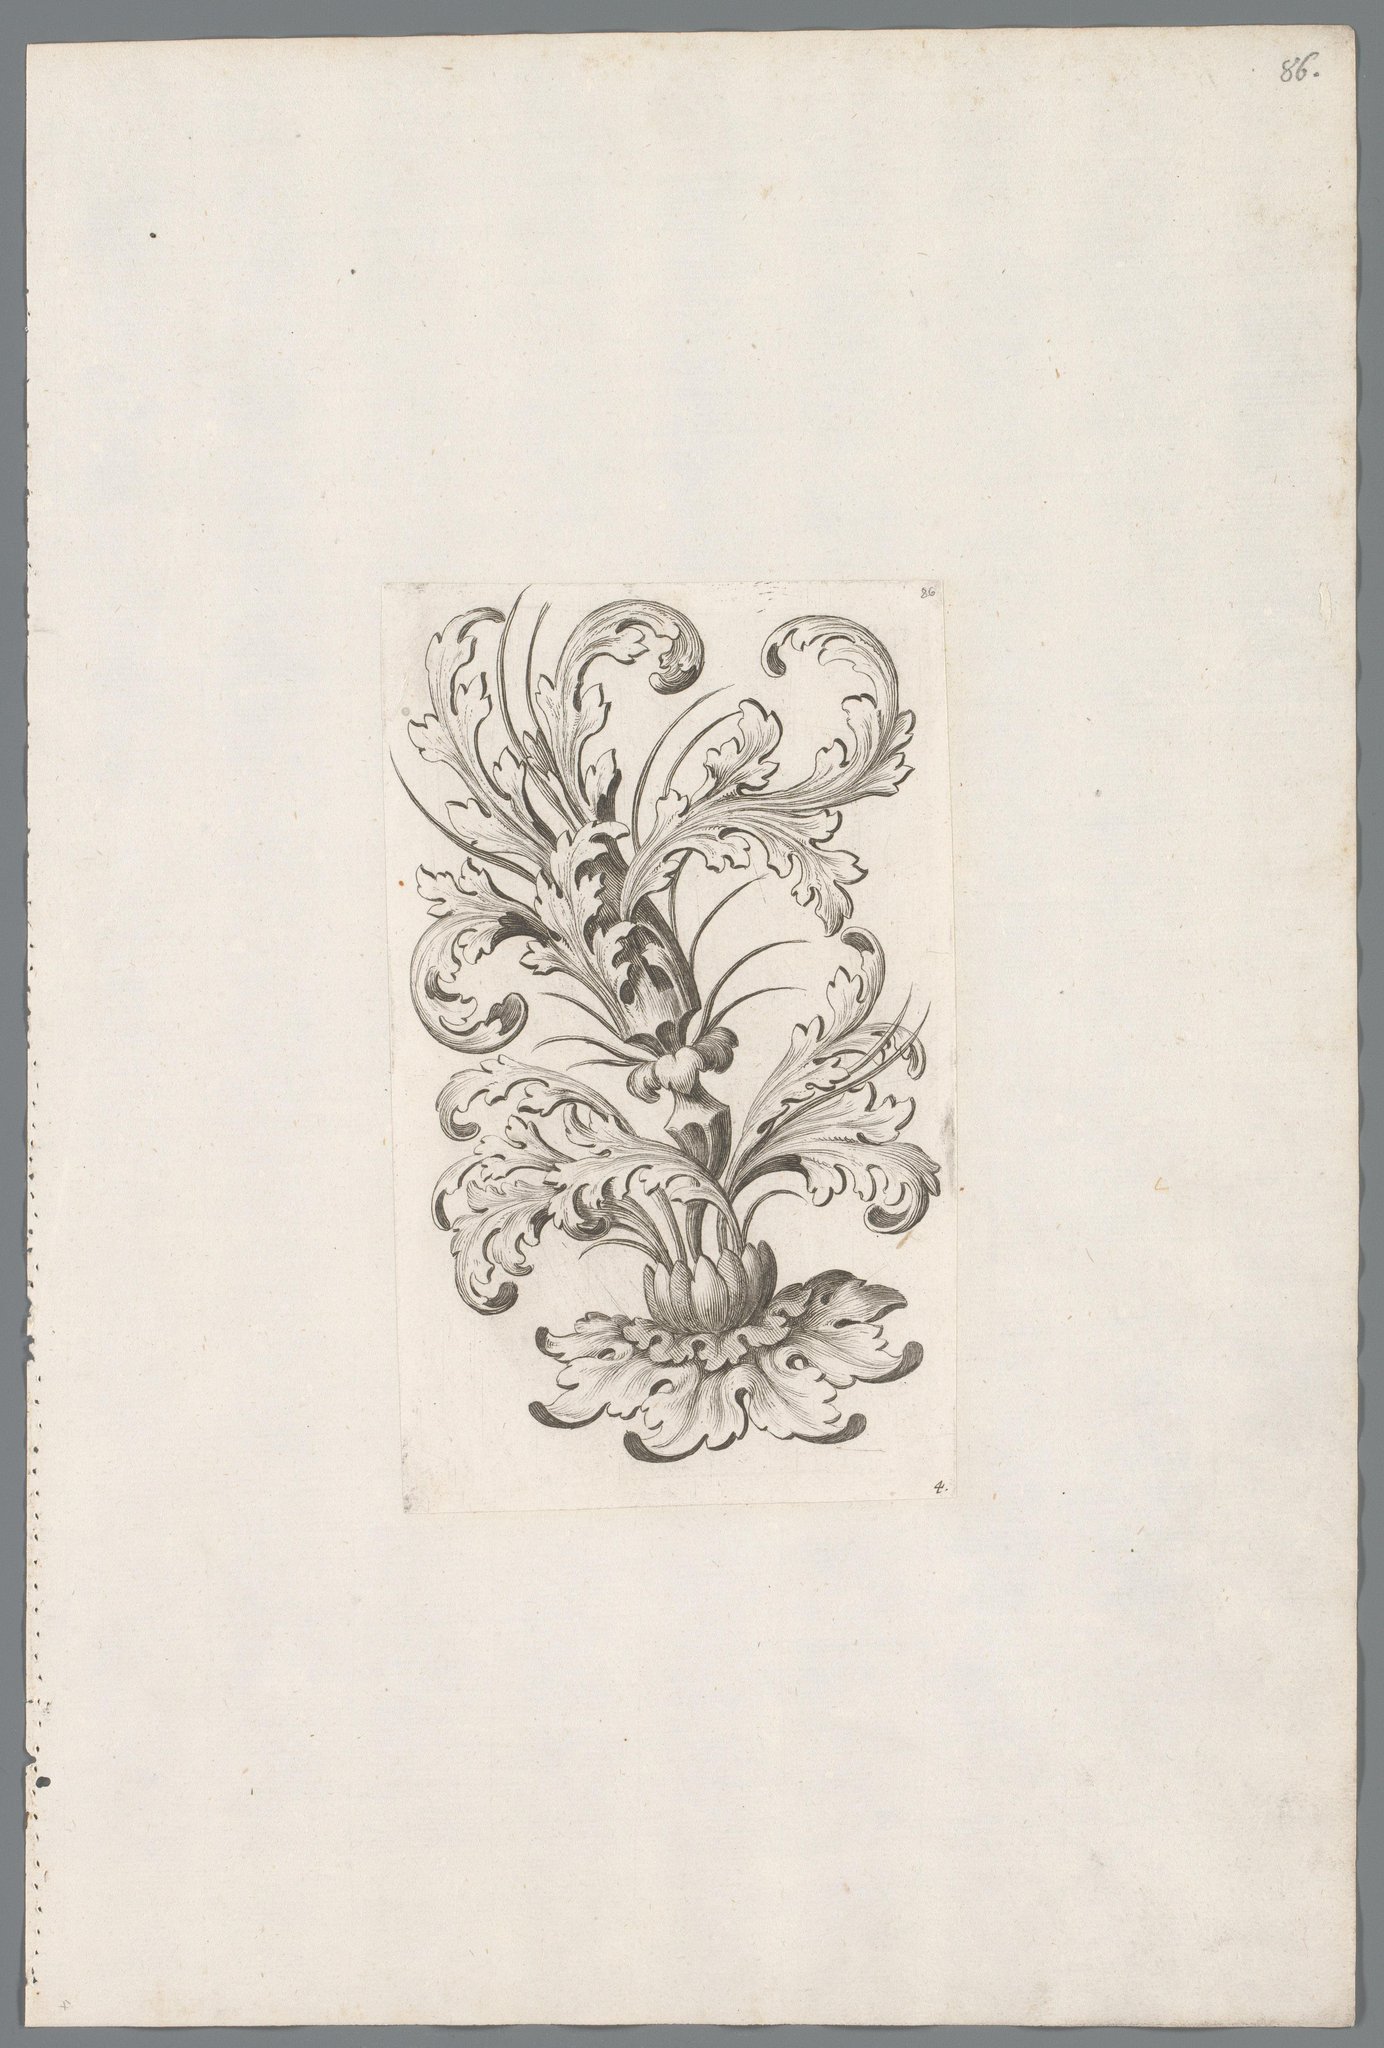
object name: print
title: Romeins gebladerte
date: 1679-1700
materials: paper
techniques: etching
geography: augsburg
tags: acanthus ~ ornament, flowers ~ ornament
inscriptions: collector's mark: Lugt 2228, collector's mark: Lugt 2760